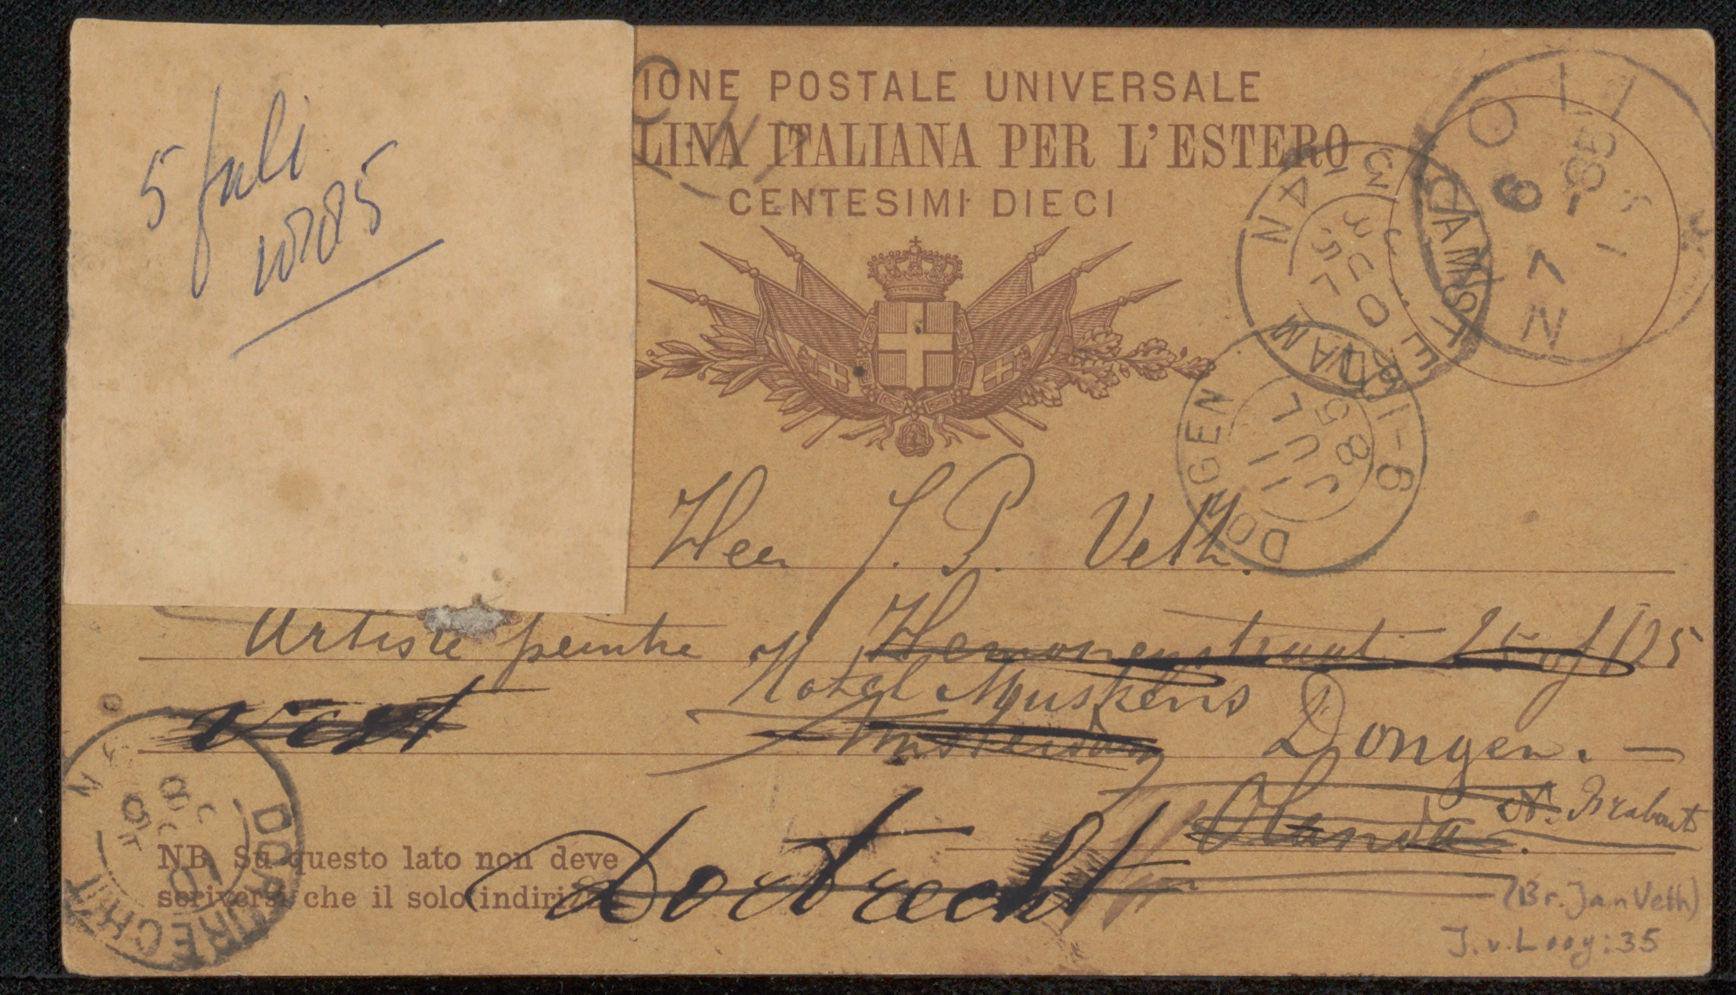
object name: postcard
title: Briefkaart aan Jan Veth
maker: jac van looij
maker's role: draughtsman, painter, print maker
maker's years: 1855-1930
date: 1885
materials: cardboard, ink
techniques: pen, writing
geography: naples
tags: august allebé, jan veth, coast, mount vesuvius, pompeii